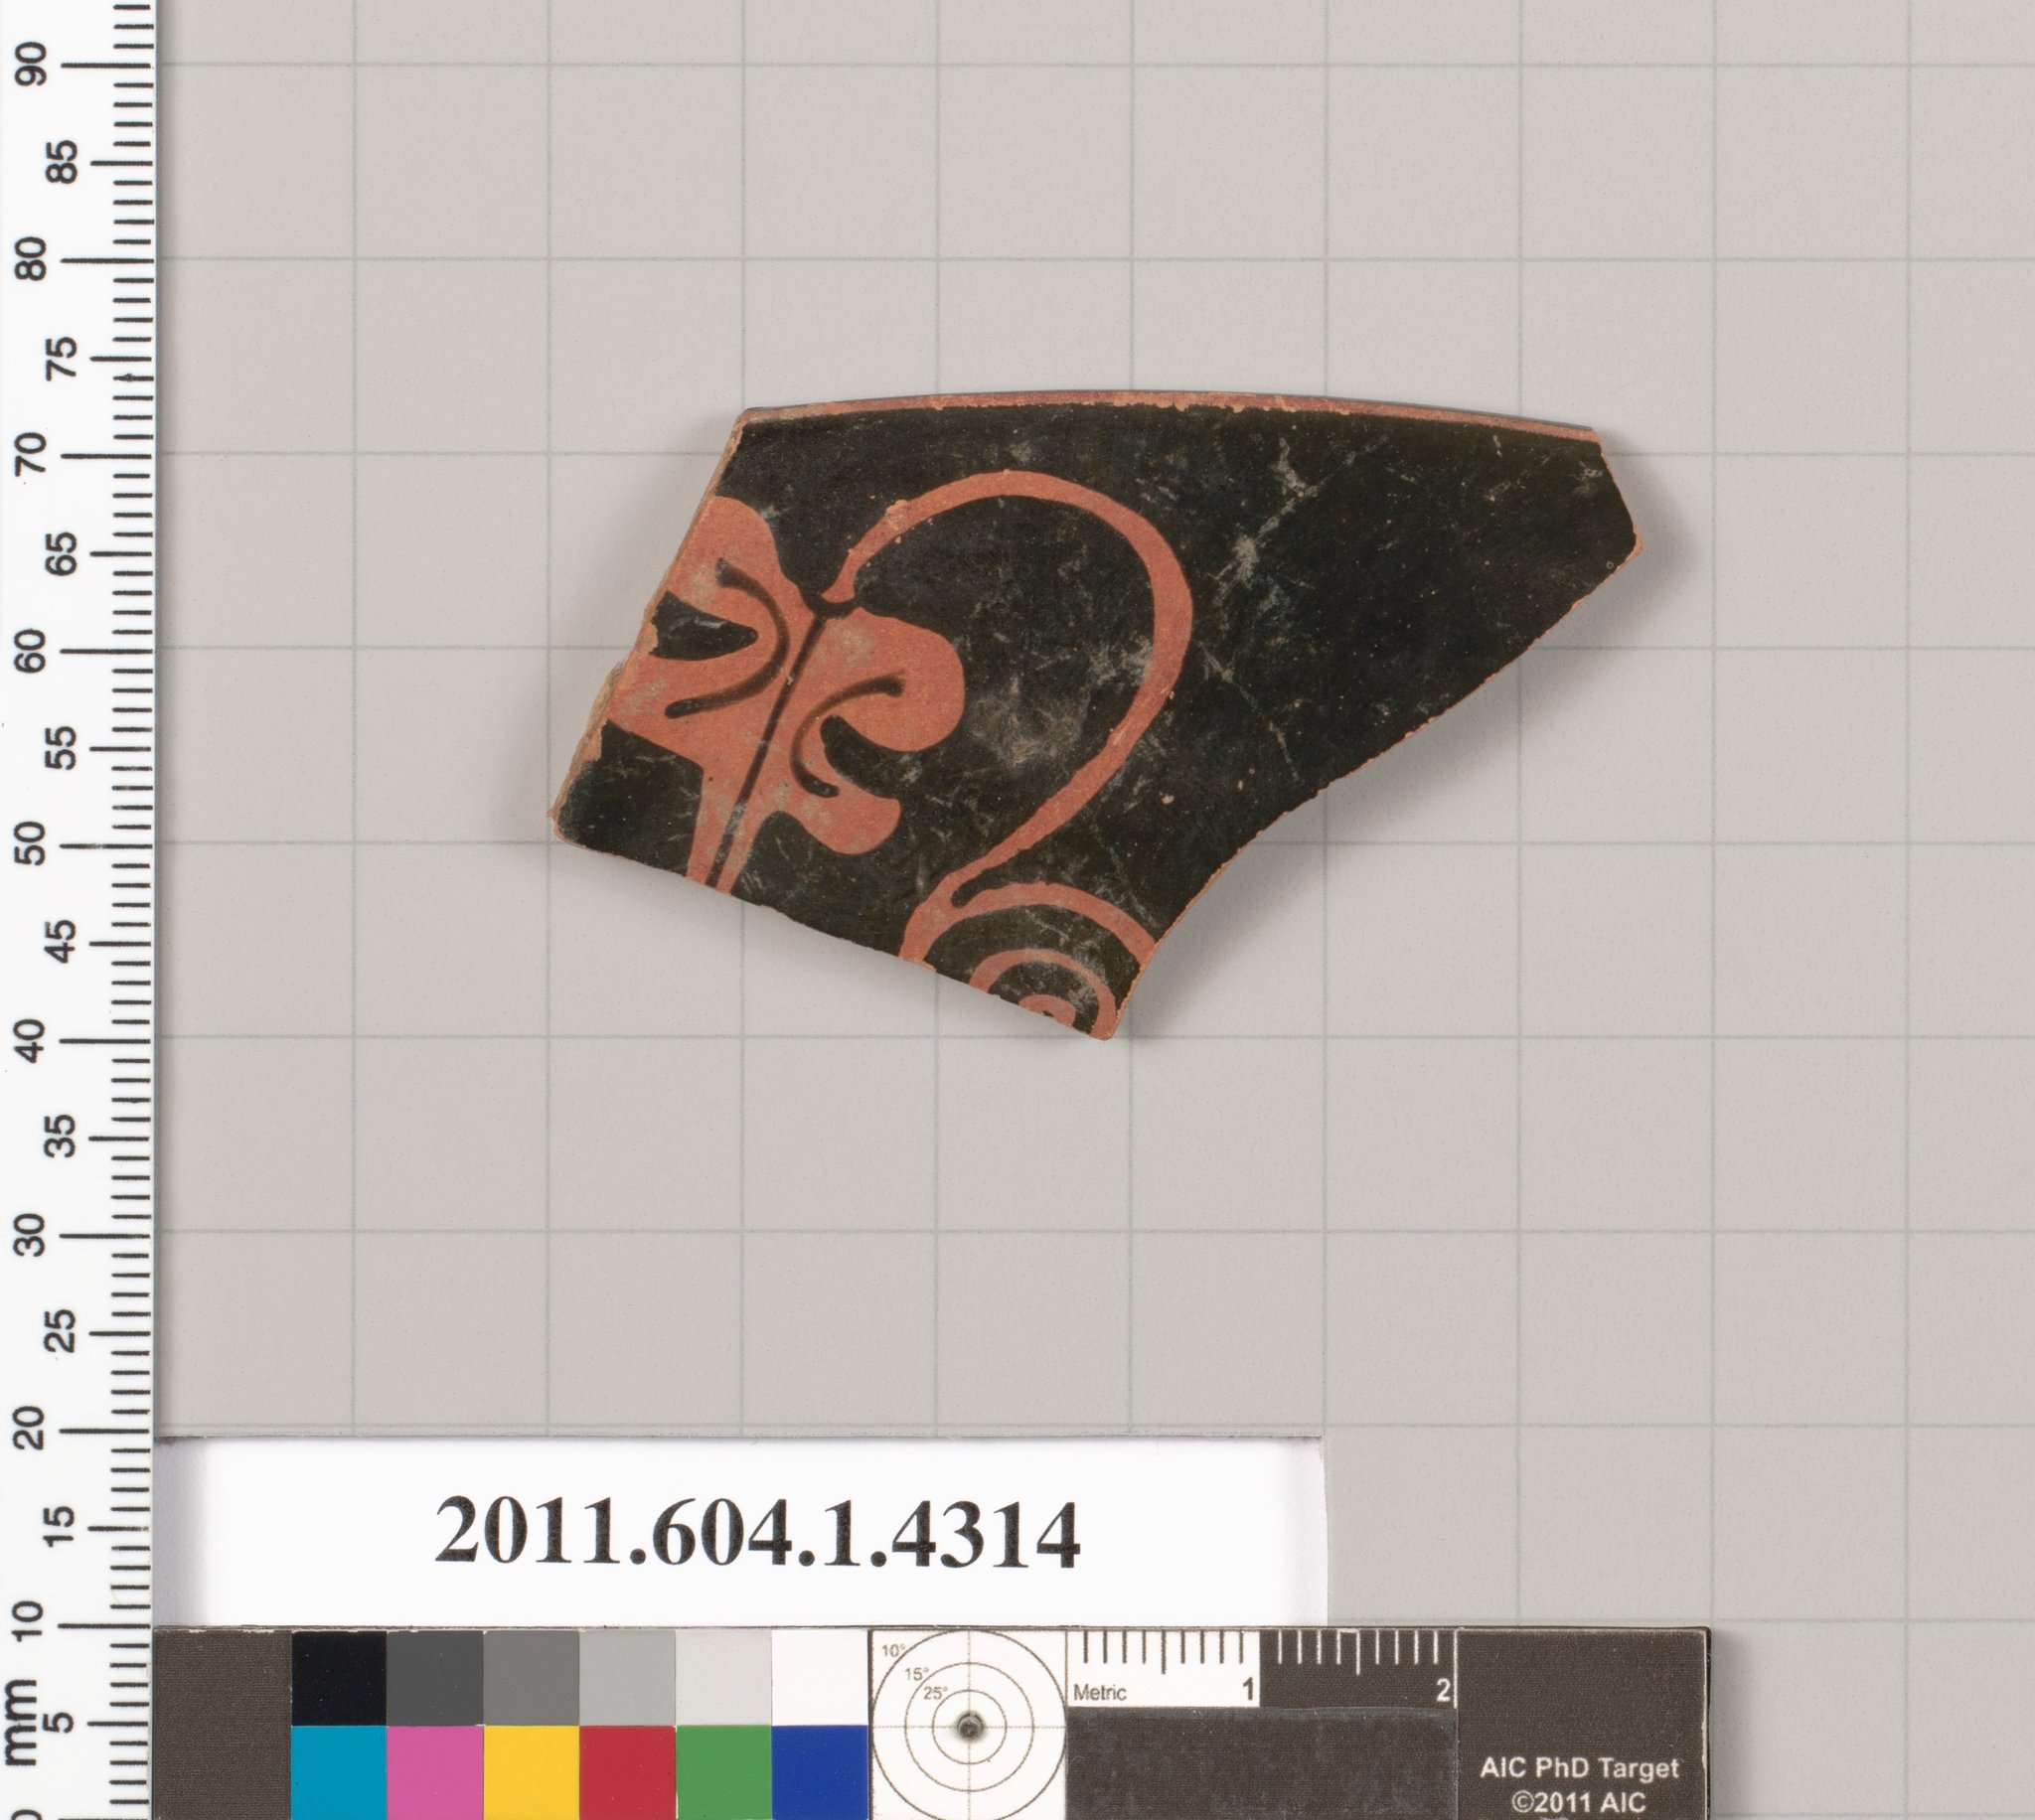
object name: kylix fragment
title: Terracotta rim fragment of a kylix (drinking cup)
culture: greek, attic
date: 500-451 BCE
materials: terracotta